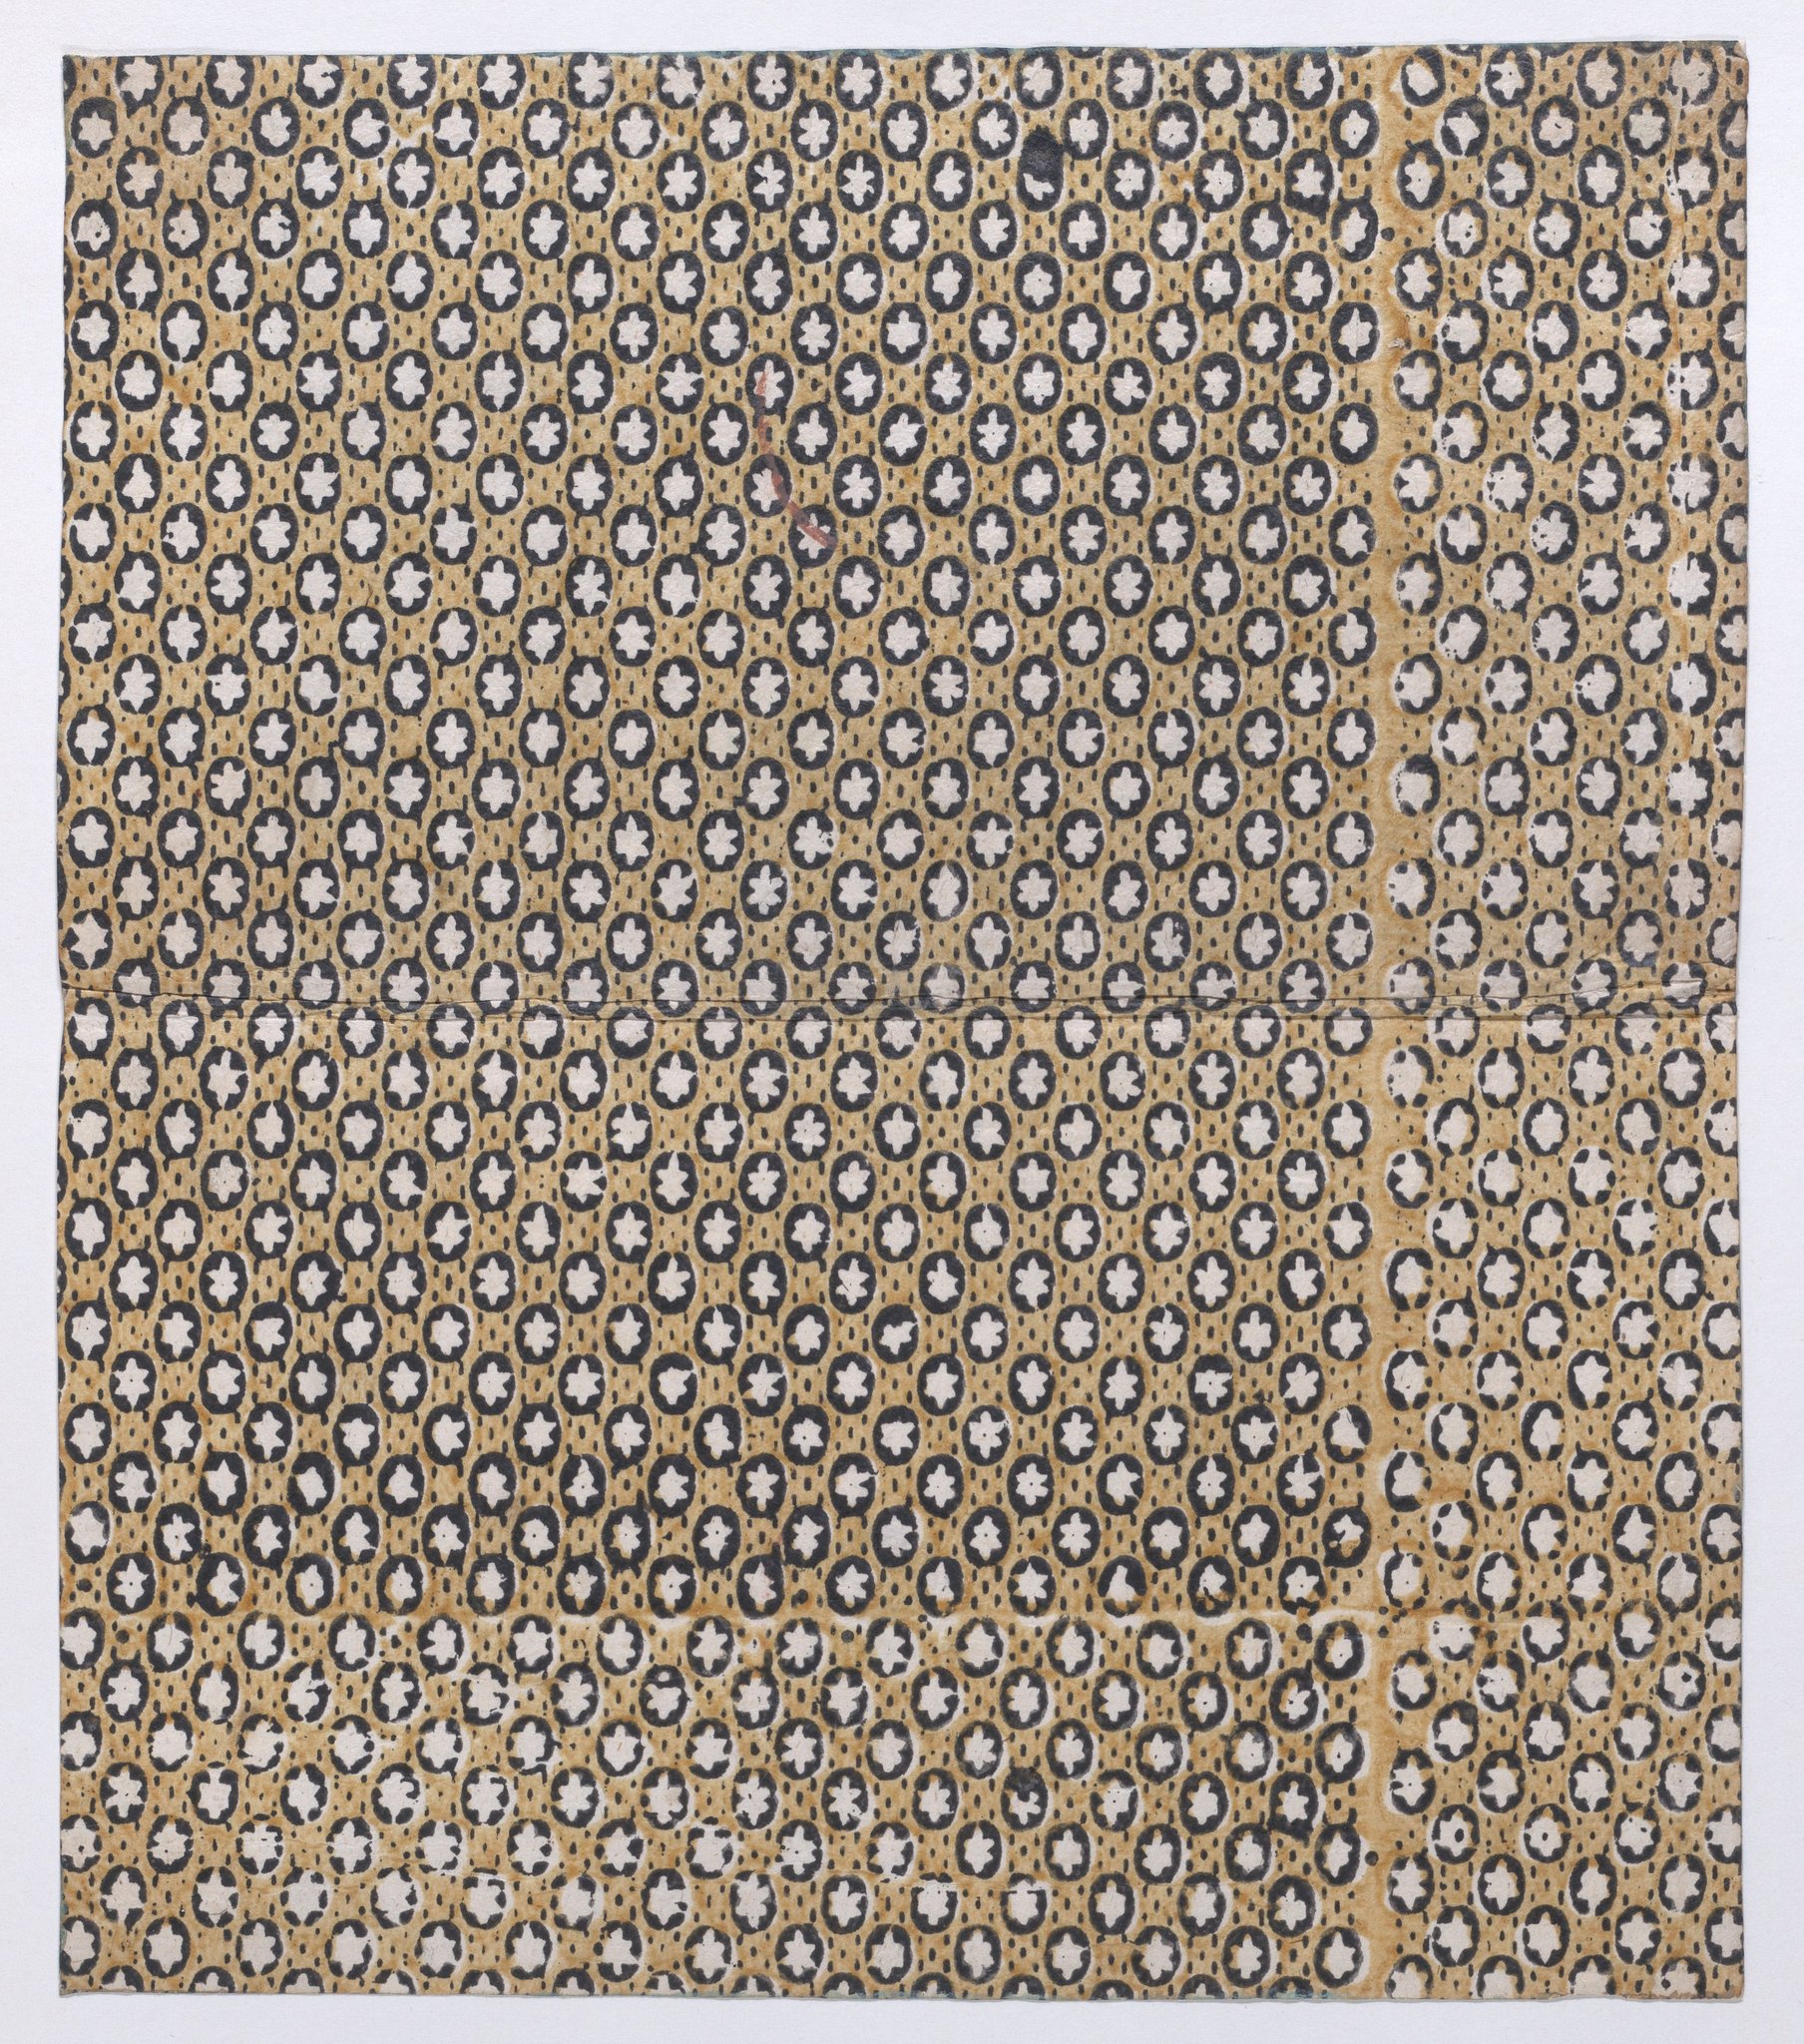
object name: print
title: Sheet with overall pattern of stars inside ovals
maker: Anonymous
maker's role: artist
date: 1801-1900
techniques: relief print